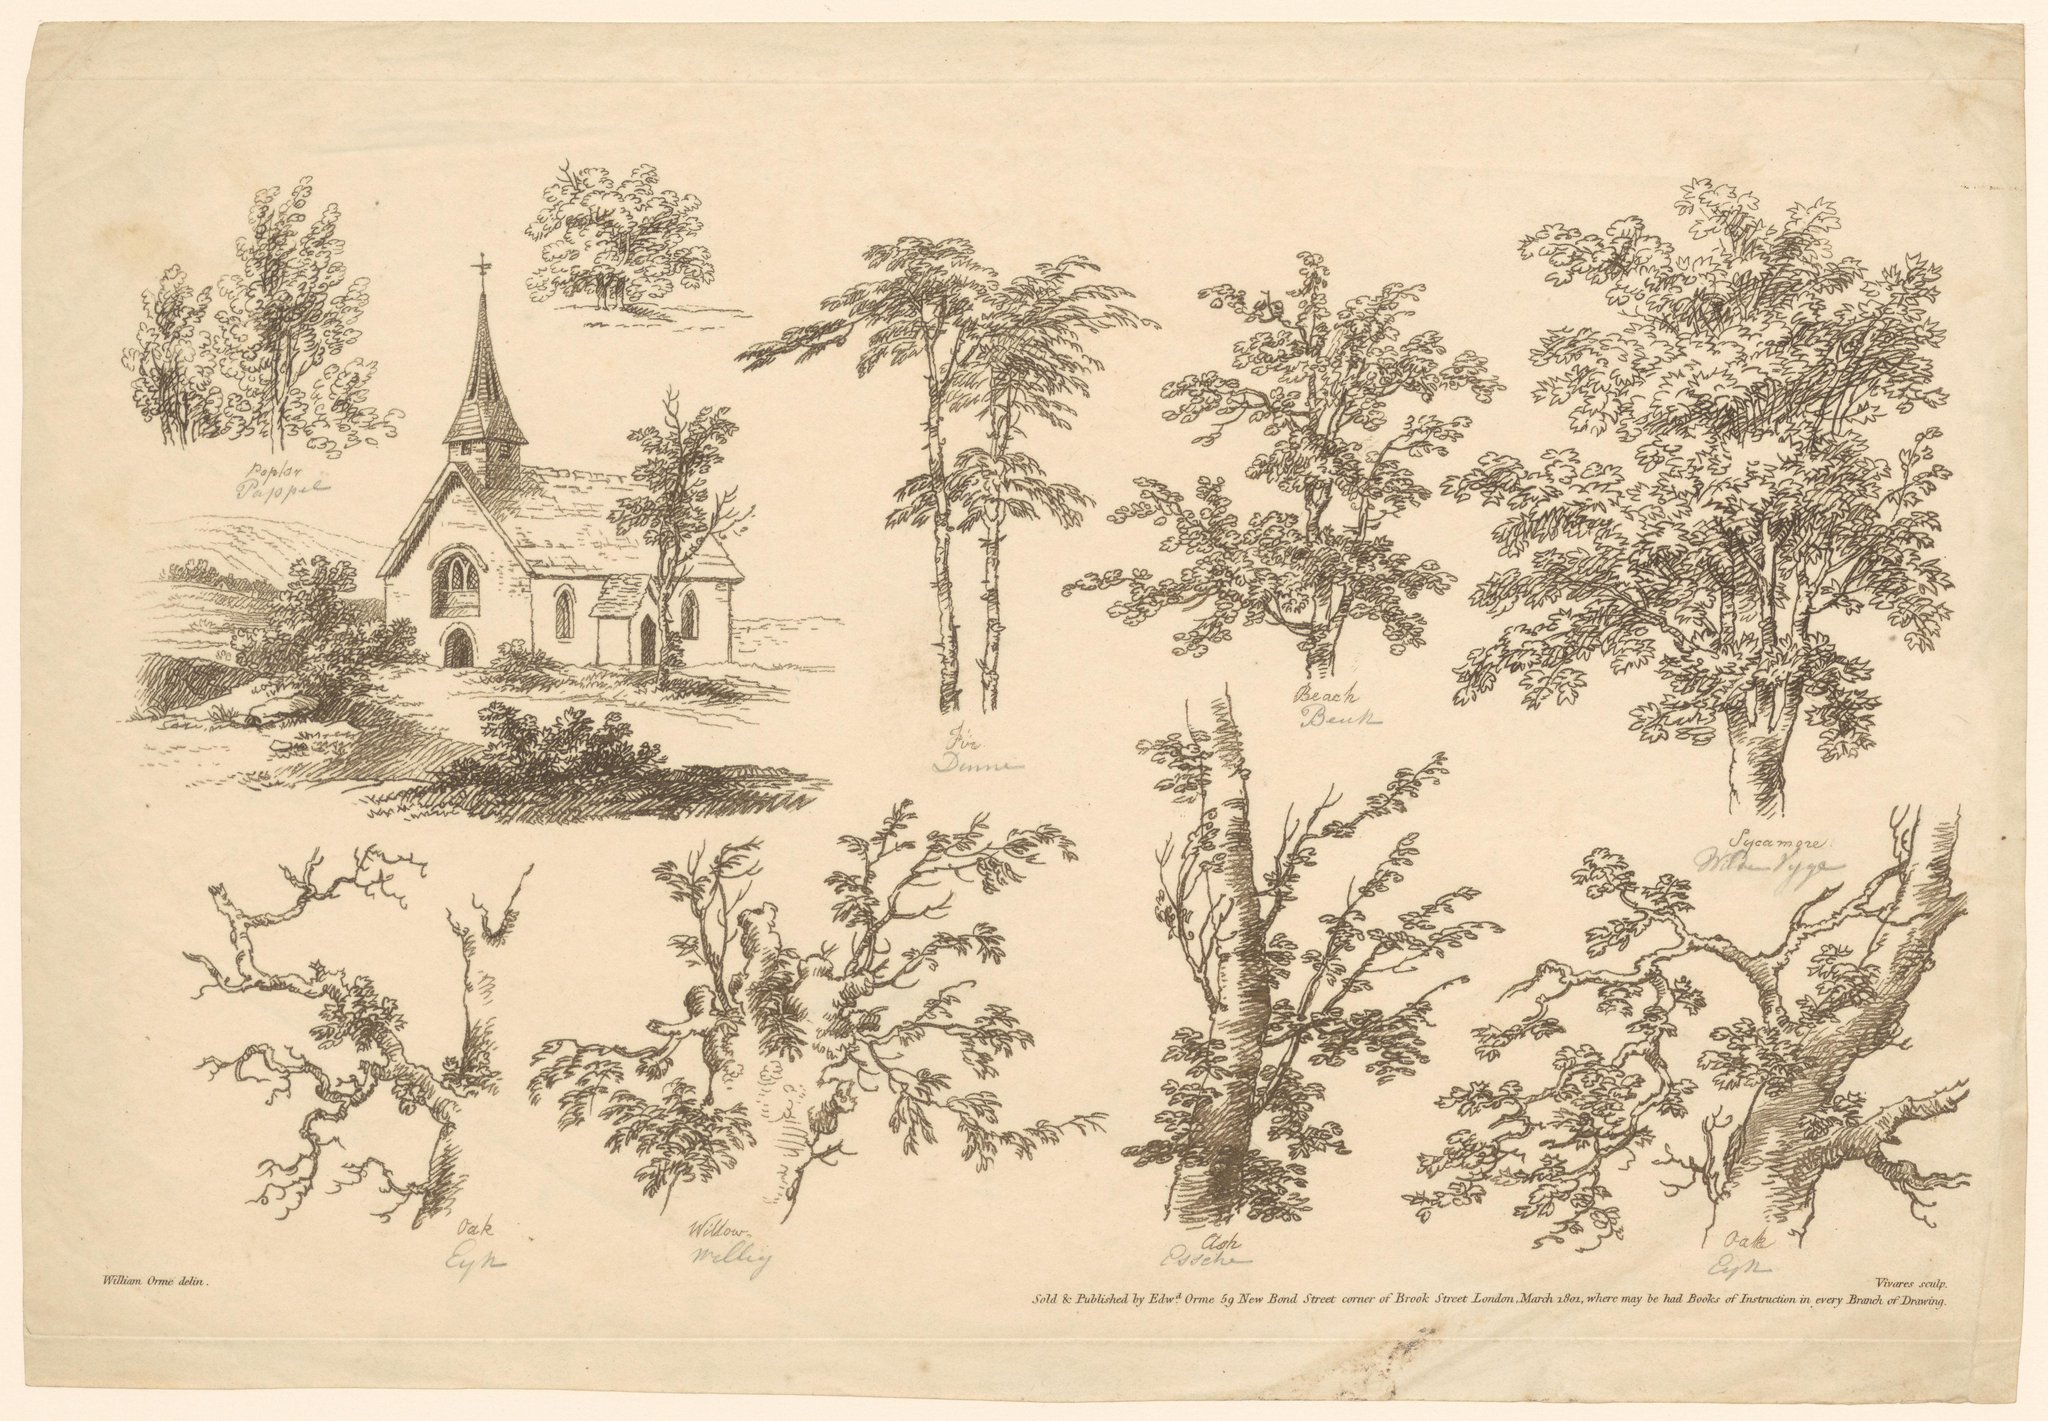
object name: print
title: Kerk en details van boomtakken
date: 1801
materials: paper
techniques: etching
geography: london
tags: the christian churches, trees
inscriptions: collector's mark: Lugt 2228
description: De namen van de verschillende boomsoorten onder de takken.